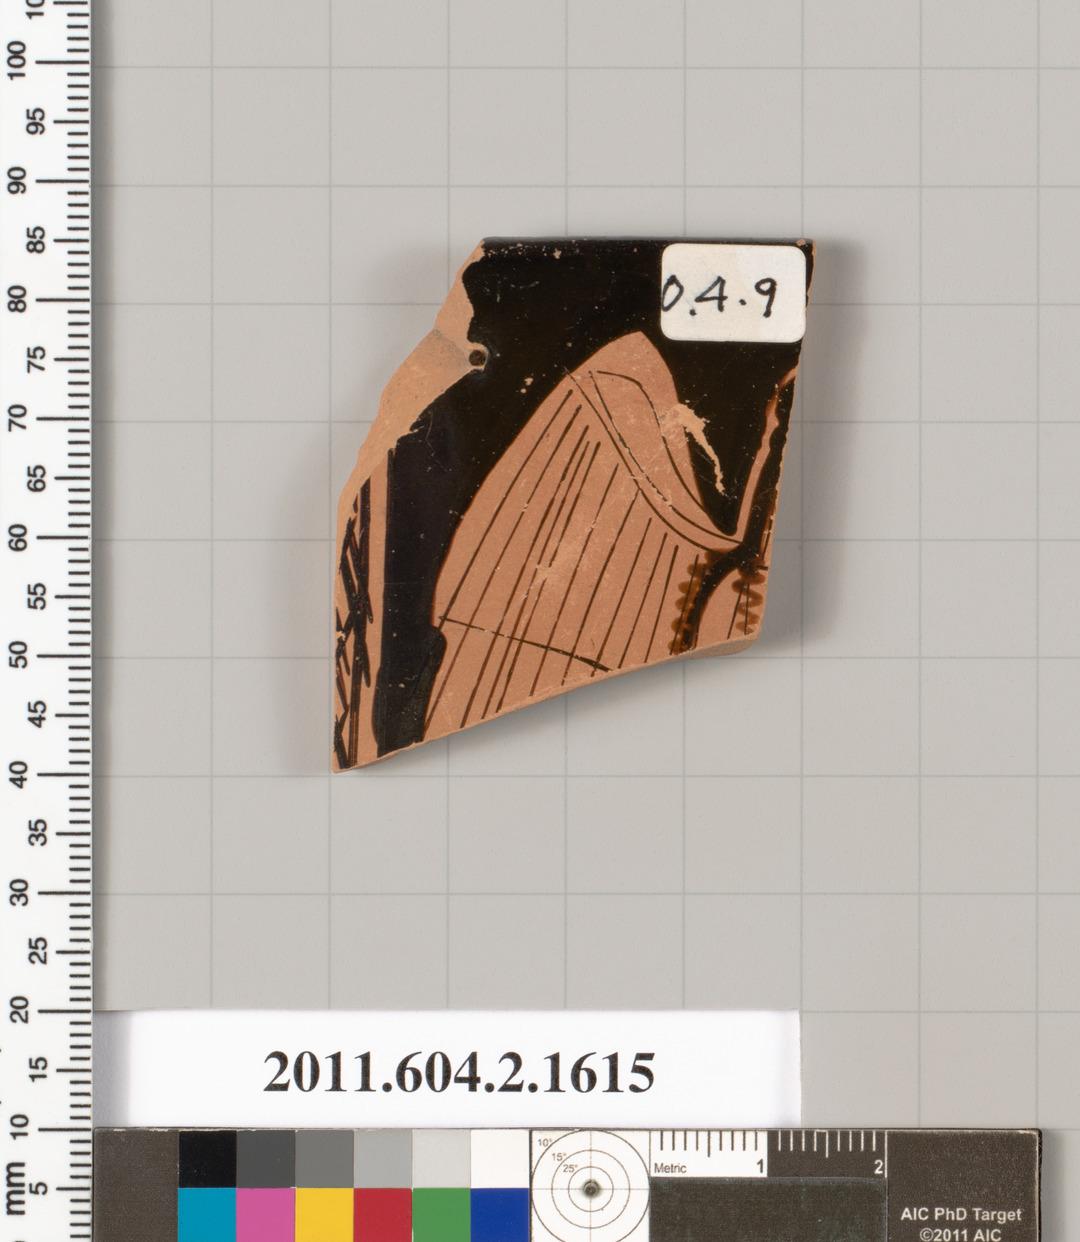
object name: skyphos fragment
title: Terracotta rim fragment of a skyphos (deep drinking cup)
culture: greek, attic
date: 450-430 BCE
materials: terracotta